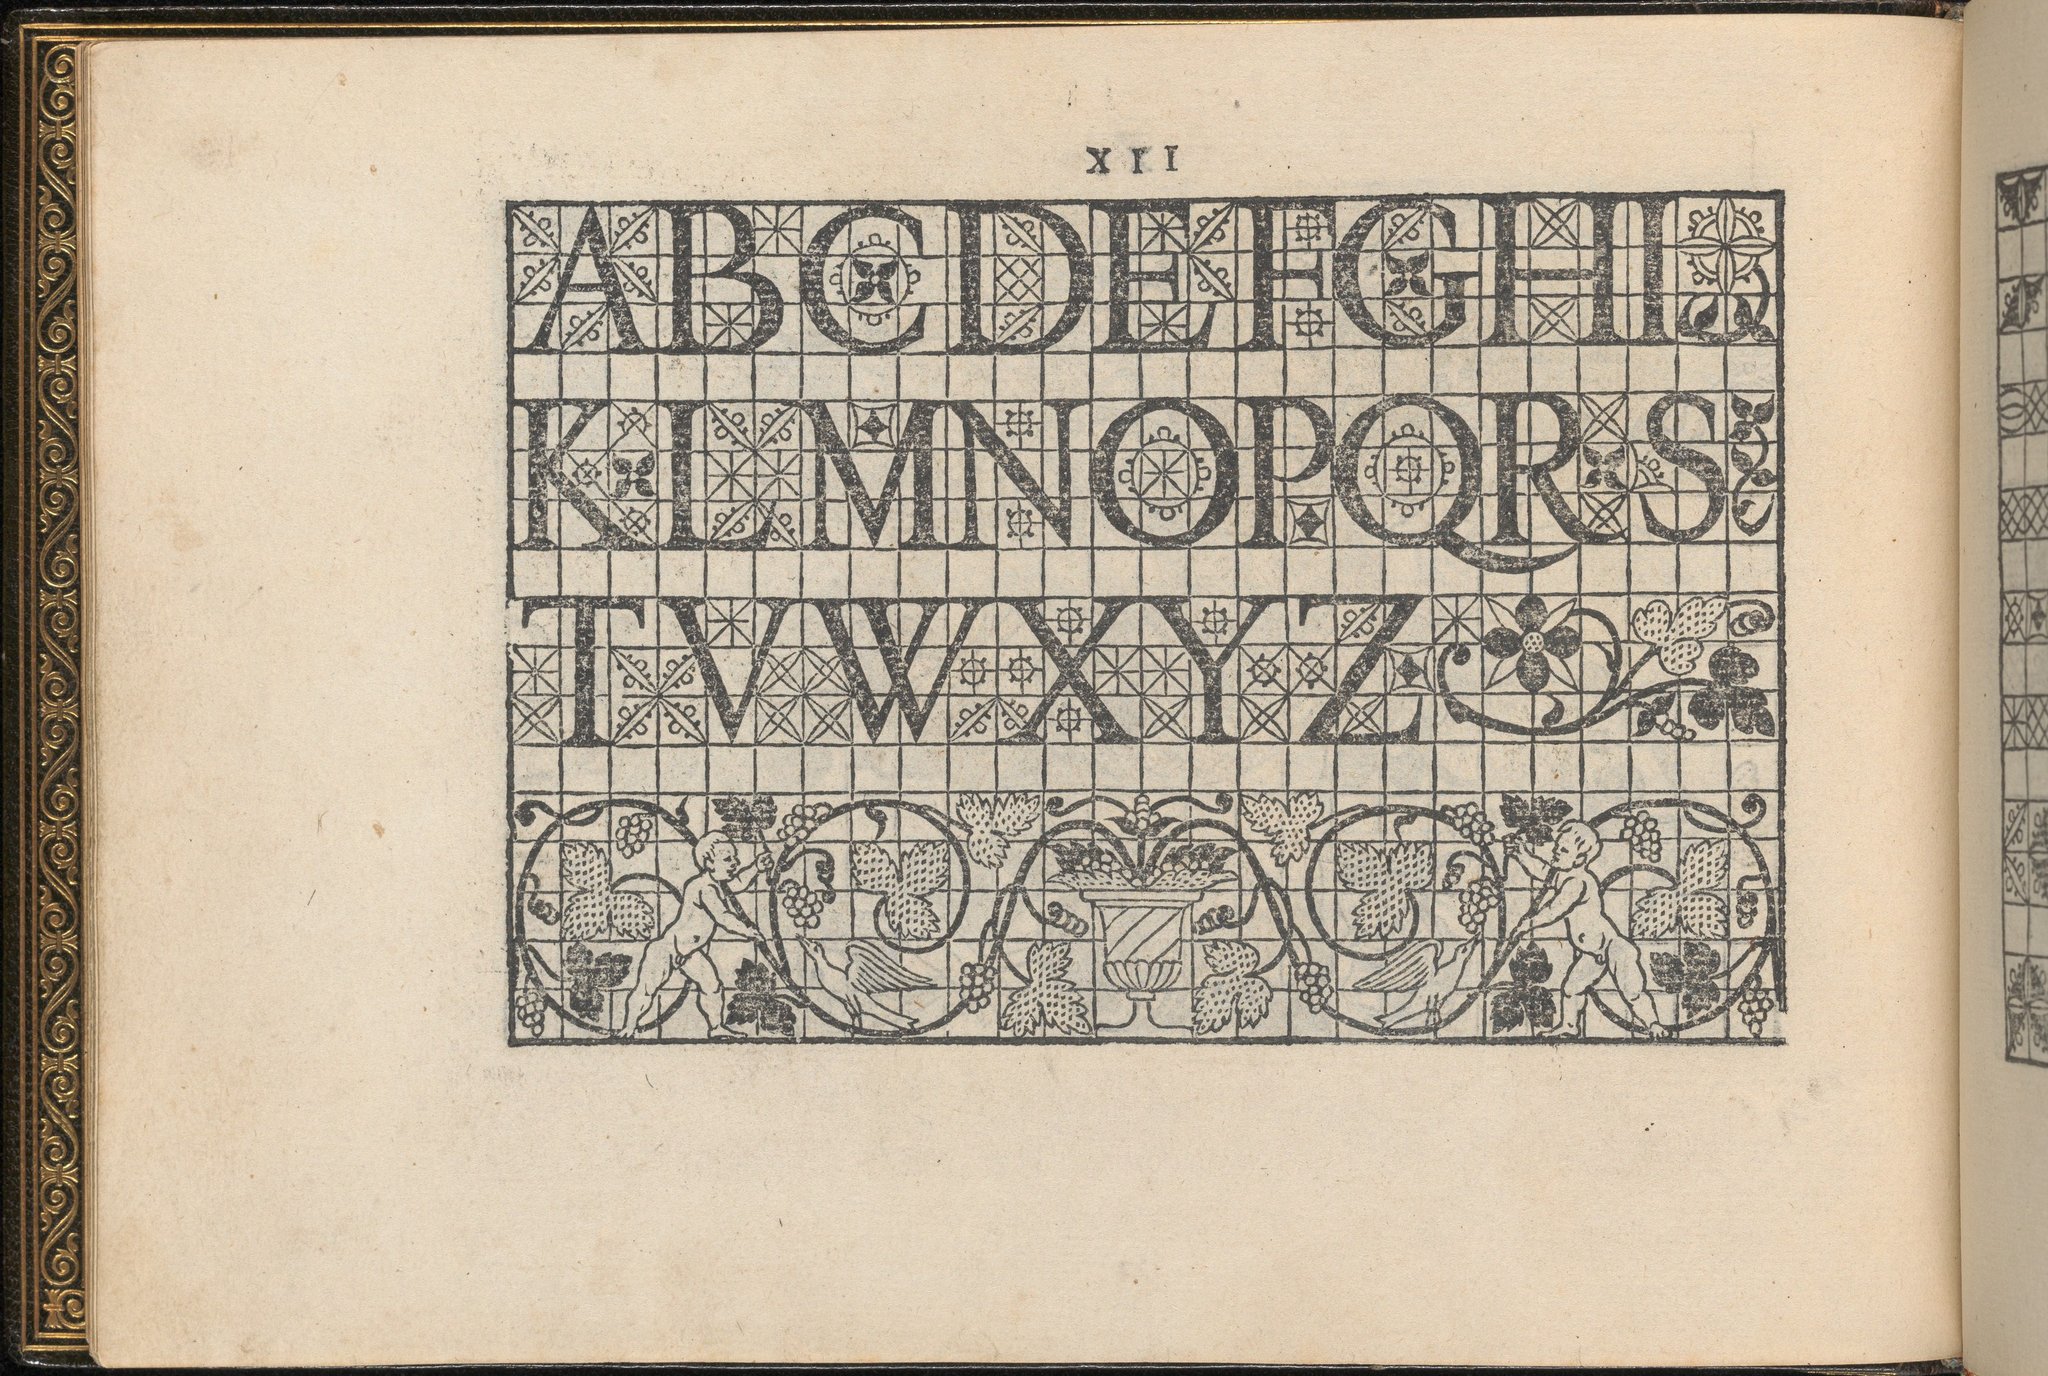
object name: book print ornament architecture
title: La Vera Perfettione del Disegno di varie sorti di recami, page 6 (verso)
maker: giovanni ostaus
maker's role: publisher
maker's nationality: italian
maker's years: 1507-1607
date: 1567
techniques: woodcut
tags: ornament,children